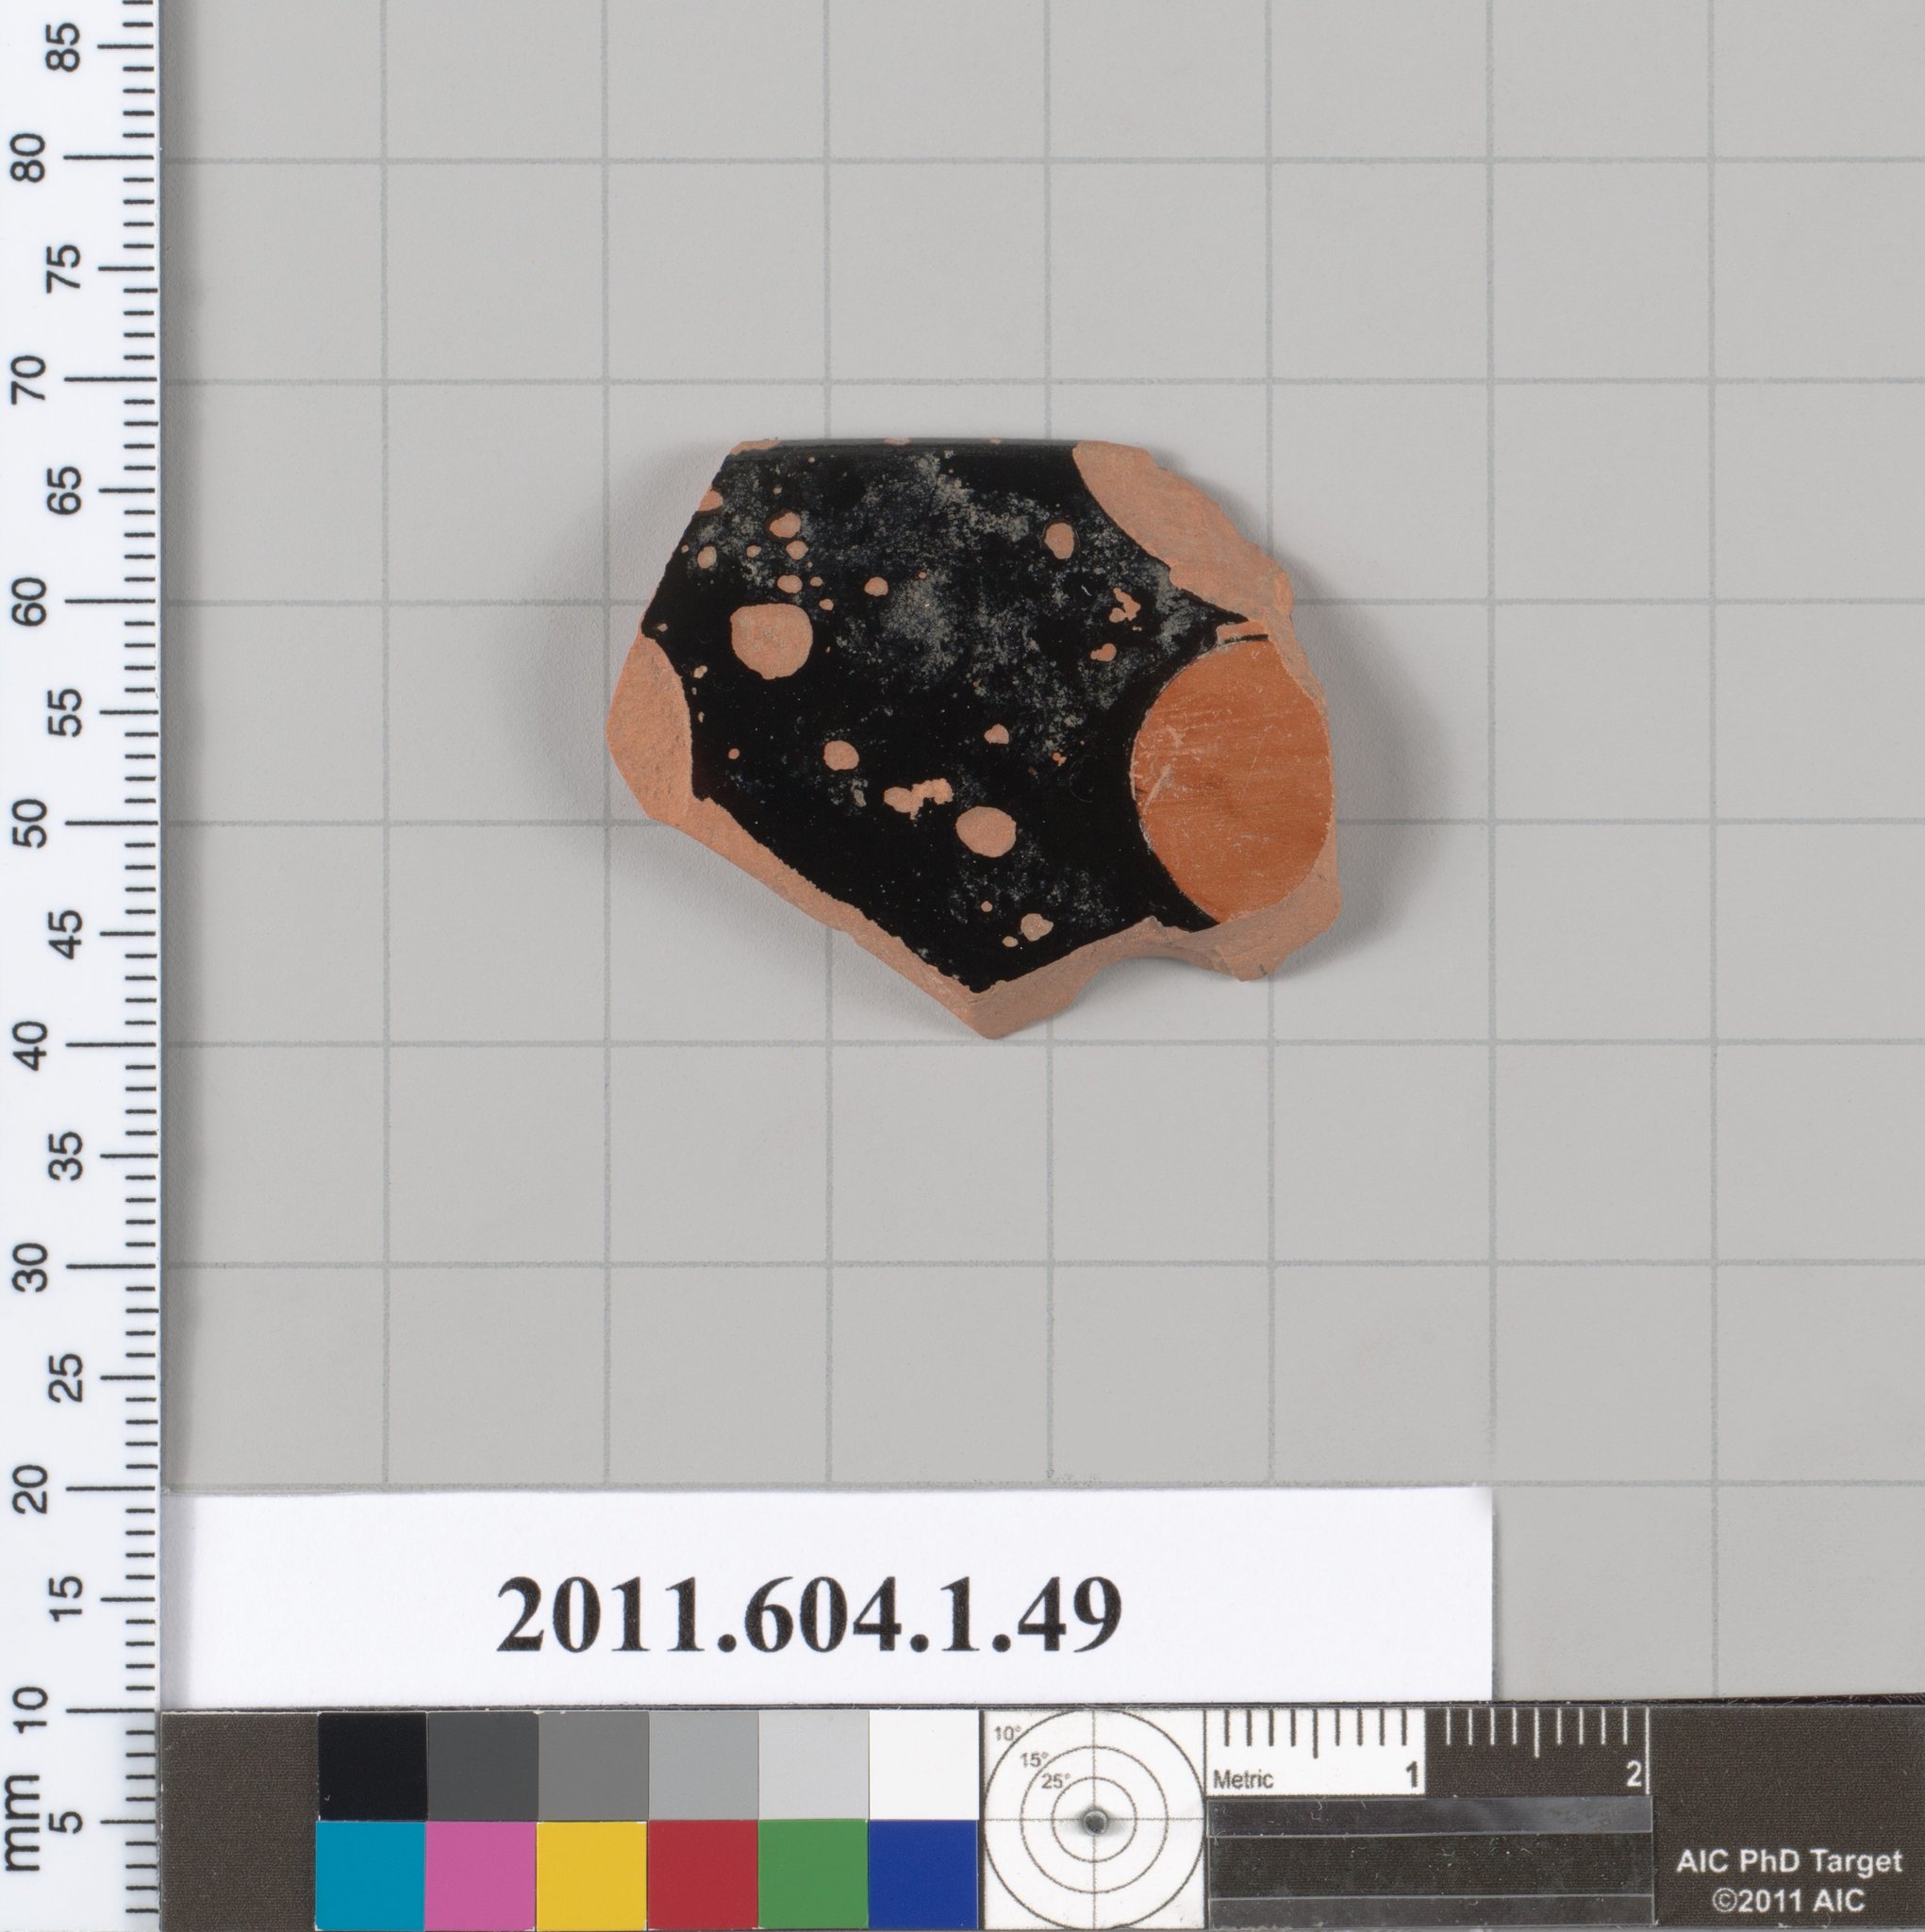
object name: kylix fragment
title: Terracotta fragment of a kylix (drinking cup)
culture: greek, attic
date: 500-470 BCE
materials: terracotta